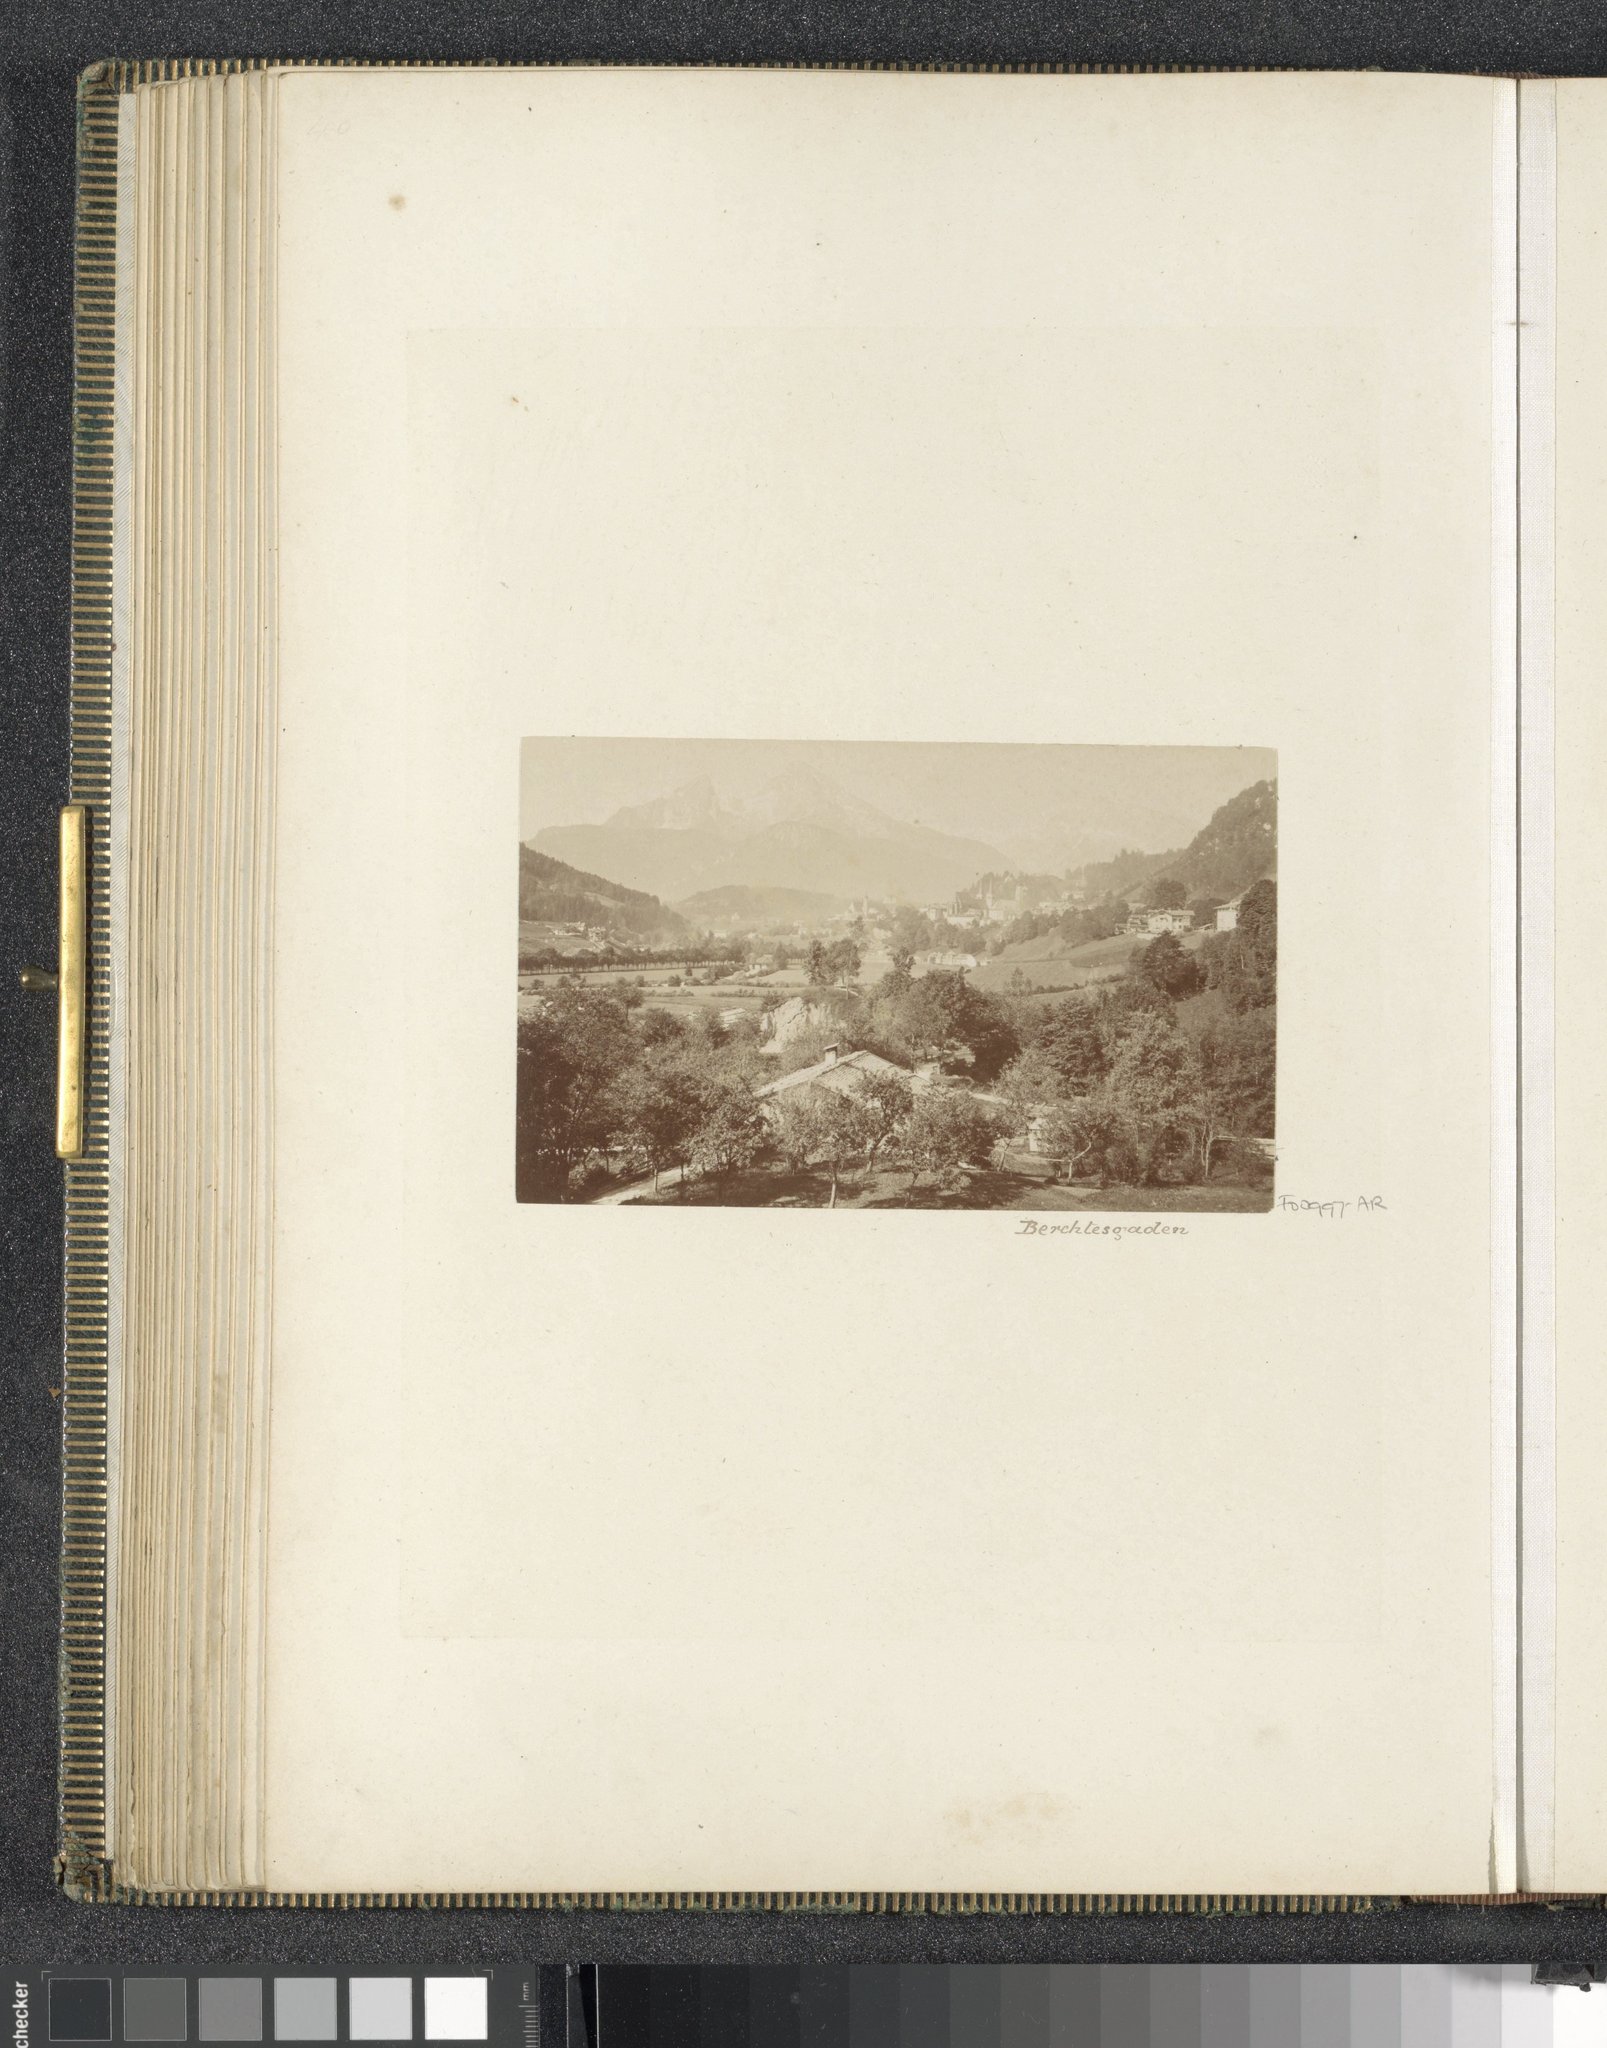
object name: photograph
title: Berchtesgaden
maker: Anonymous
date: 1860-1890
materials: paper, photographic support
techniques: albumen print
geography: berchtesgaden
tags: prospect of village, silhouette of village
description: Onderdeel van Reisalbum met foto's van Zwitserland, Oostenrijk, Italië en Duitsland.